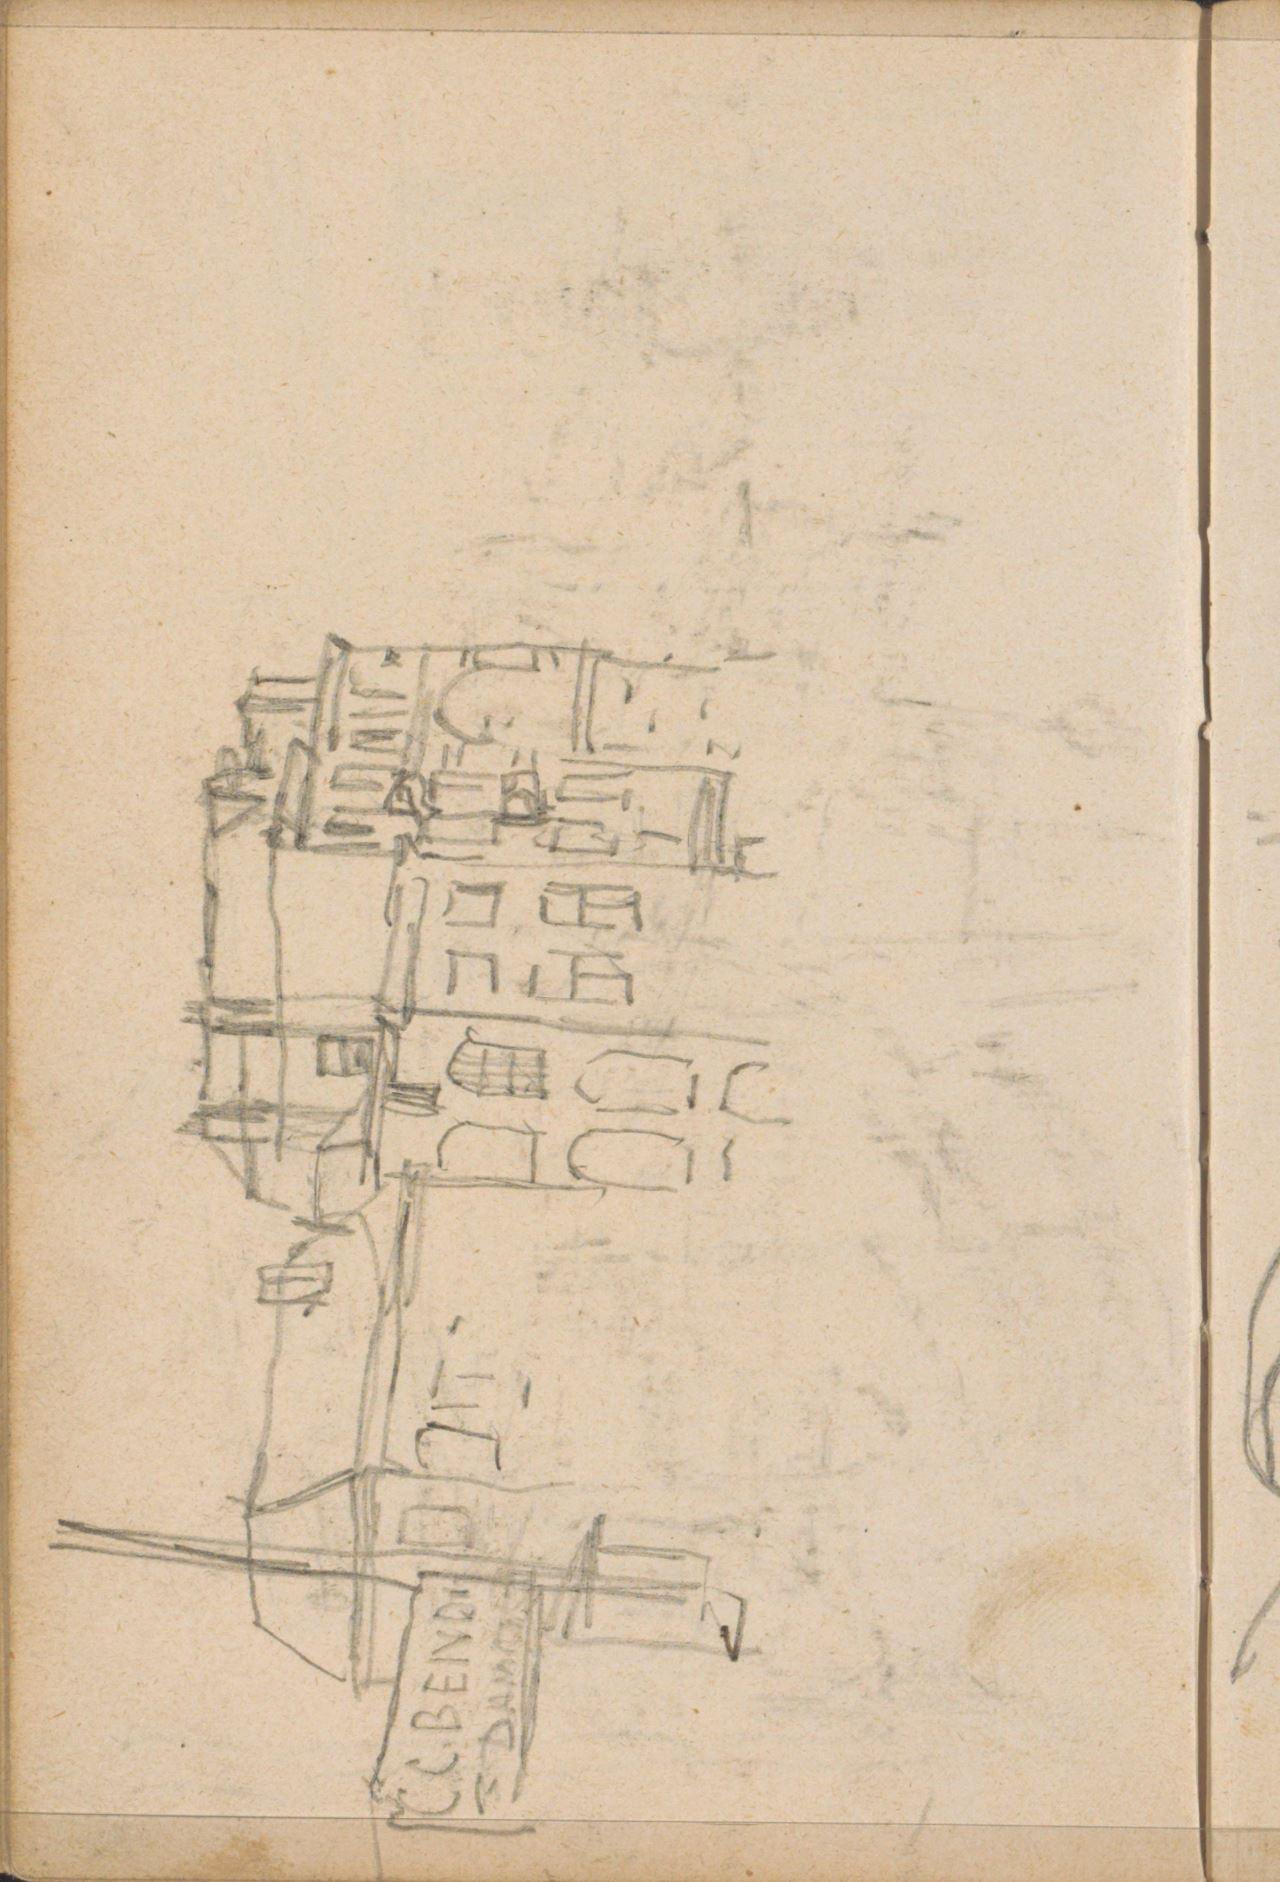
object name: sketchbook leaf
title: Gezicht op gebouwen aan het Damrak te Amsterdam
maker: george hendrik breitner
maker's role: draughtsman, painter, print maker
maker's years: 1857-1923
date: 1903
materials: paper, pencil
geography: amsterdam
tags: urban housing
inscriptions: annotation: ‘C.C. Bendi[?]/ [...] Damrak’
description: Gezicht op gebouwen aan het Damrak te Amsterdam. Pagina 27 uit een schetsboek met 46 bladen vervaardigd te Amsterdam en Haarlem.